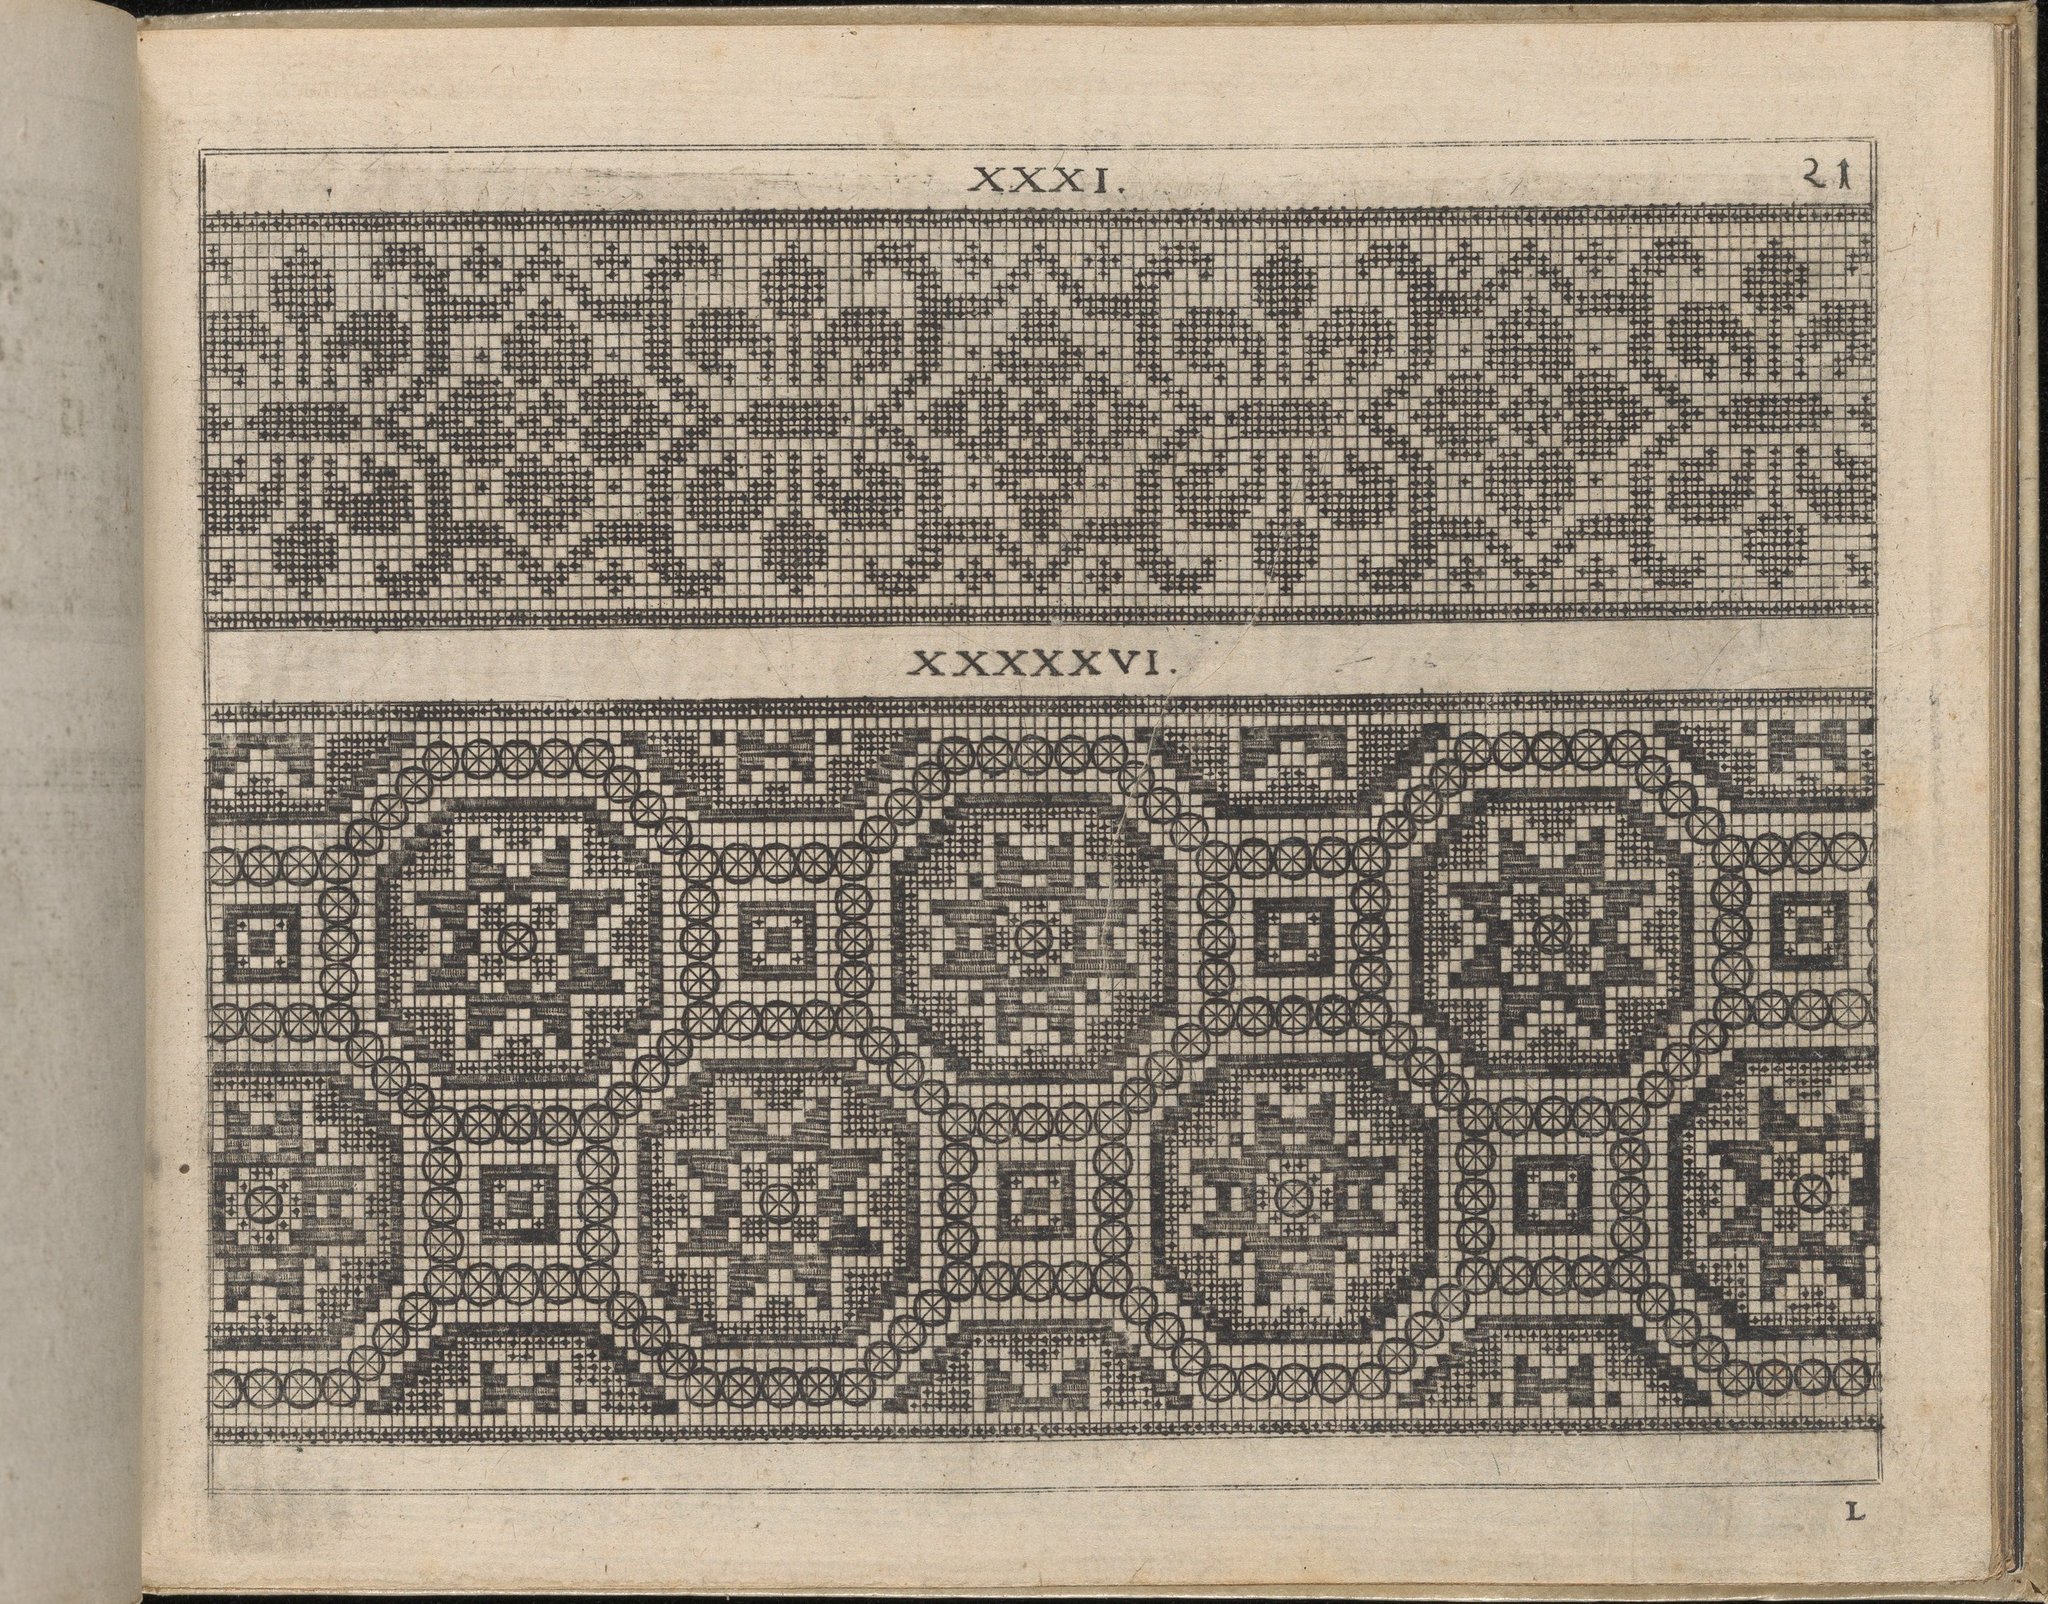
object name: book print ornament architecture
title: Newes Modelbuch in Kupffer (Page 30r)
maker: johann sibmacher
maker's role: artist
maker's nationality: german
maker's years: 1590-1611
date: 1604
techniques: etching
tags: ornament